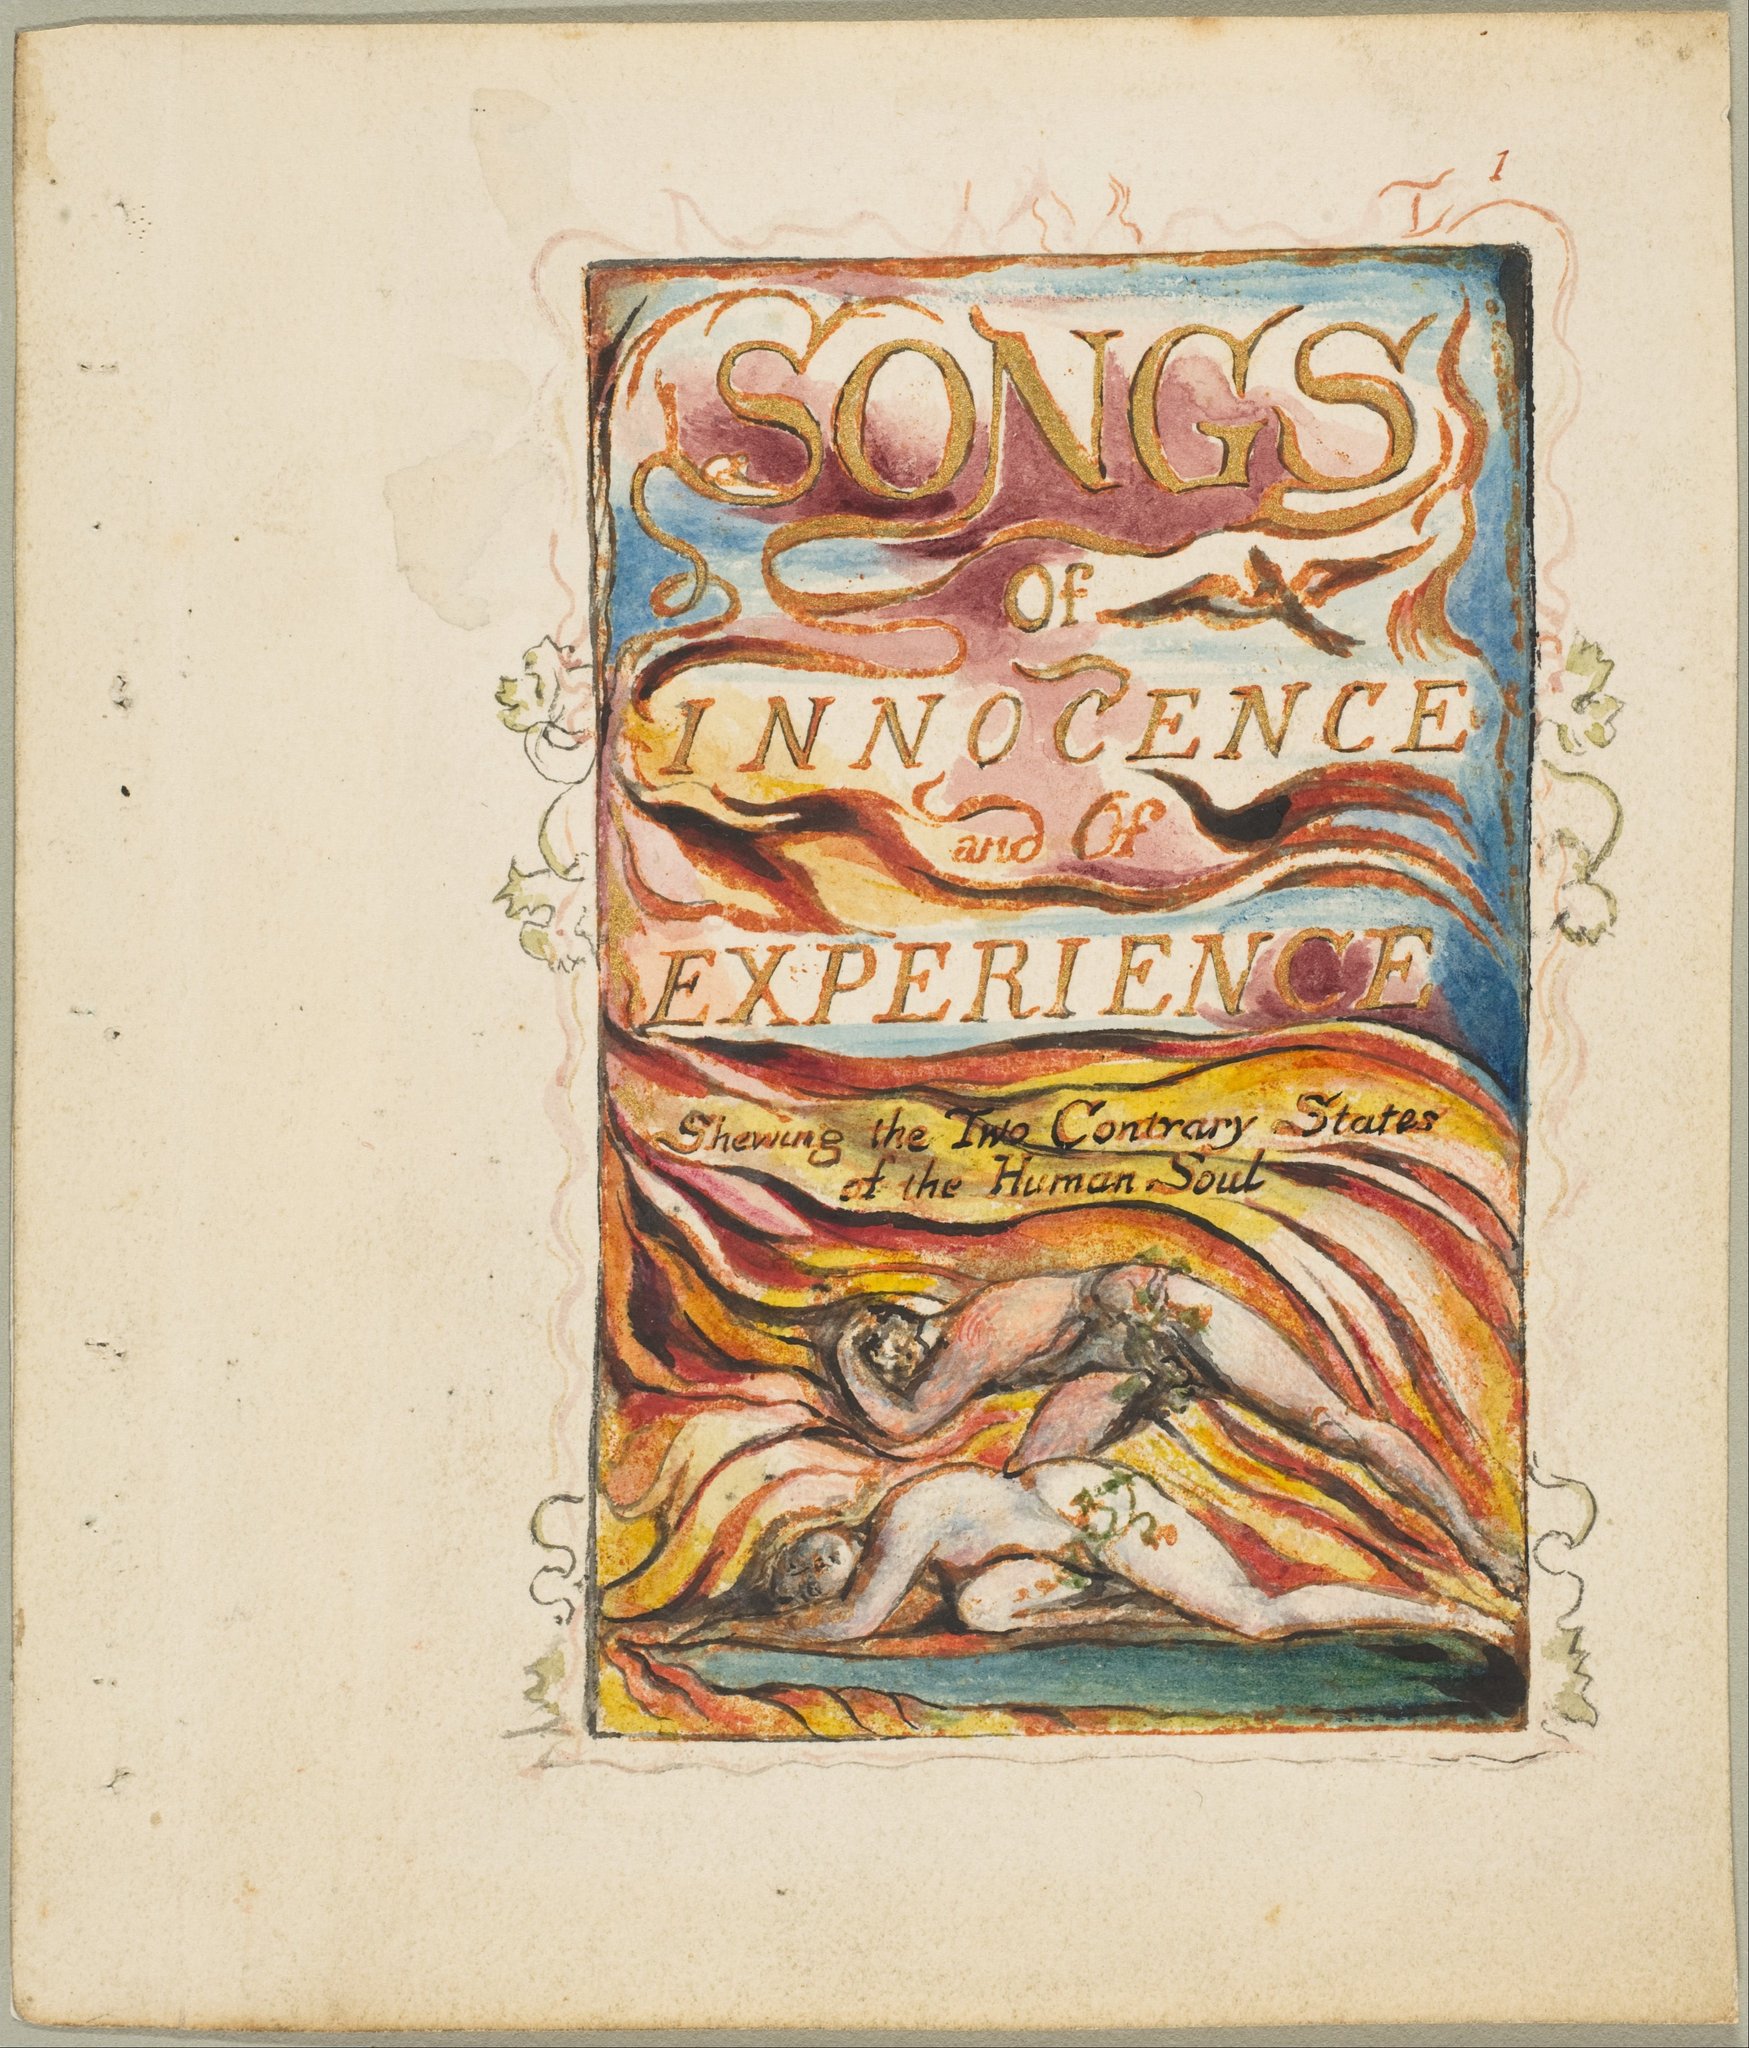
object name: print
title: Songs of Innocence and of Experience: Shewing the Two Contrary States of the Human Soul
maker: william blake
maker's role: artist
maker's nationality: british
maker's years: 1757-1827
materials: gold, ink, shell, watercolor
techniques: etching, hand coloring, printing, relief